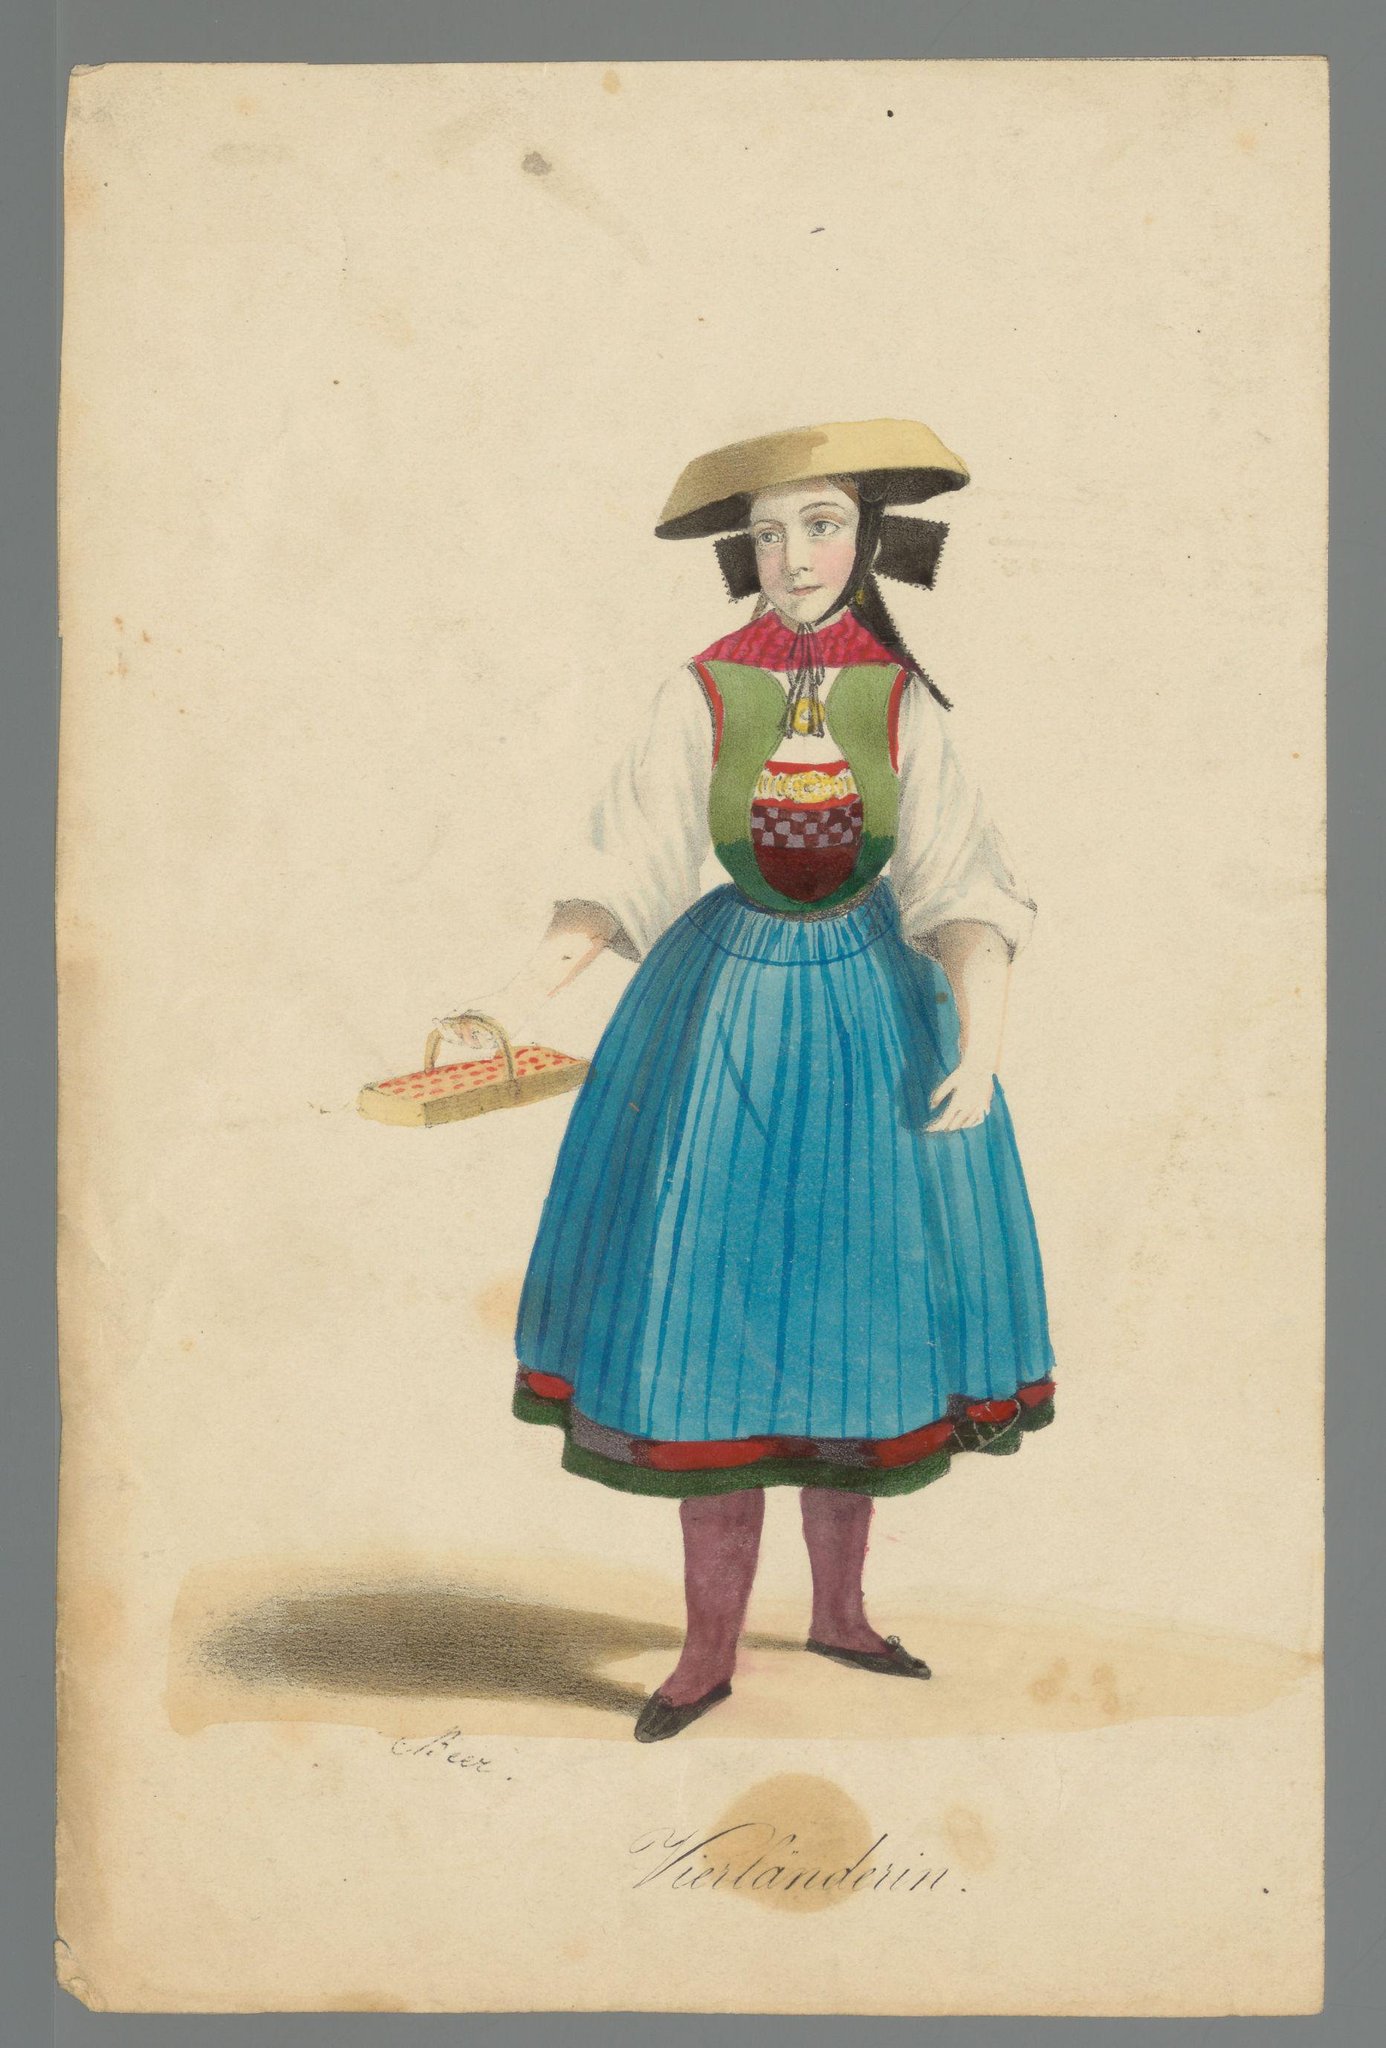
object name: print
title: Vrouw met klederdracht uit Vierlande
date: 1825-1875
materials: paper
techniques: hand coloring, lithograph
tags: adult woman, folk costume, regional costume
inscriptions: collector's mark: Lugt 2228